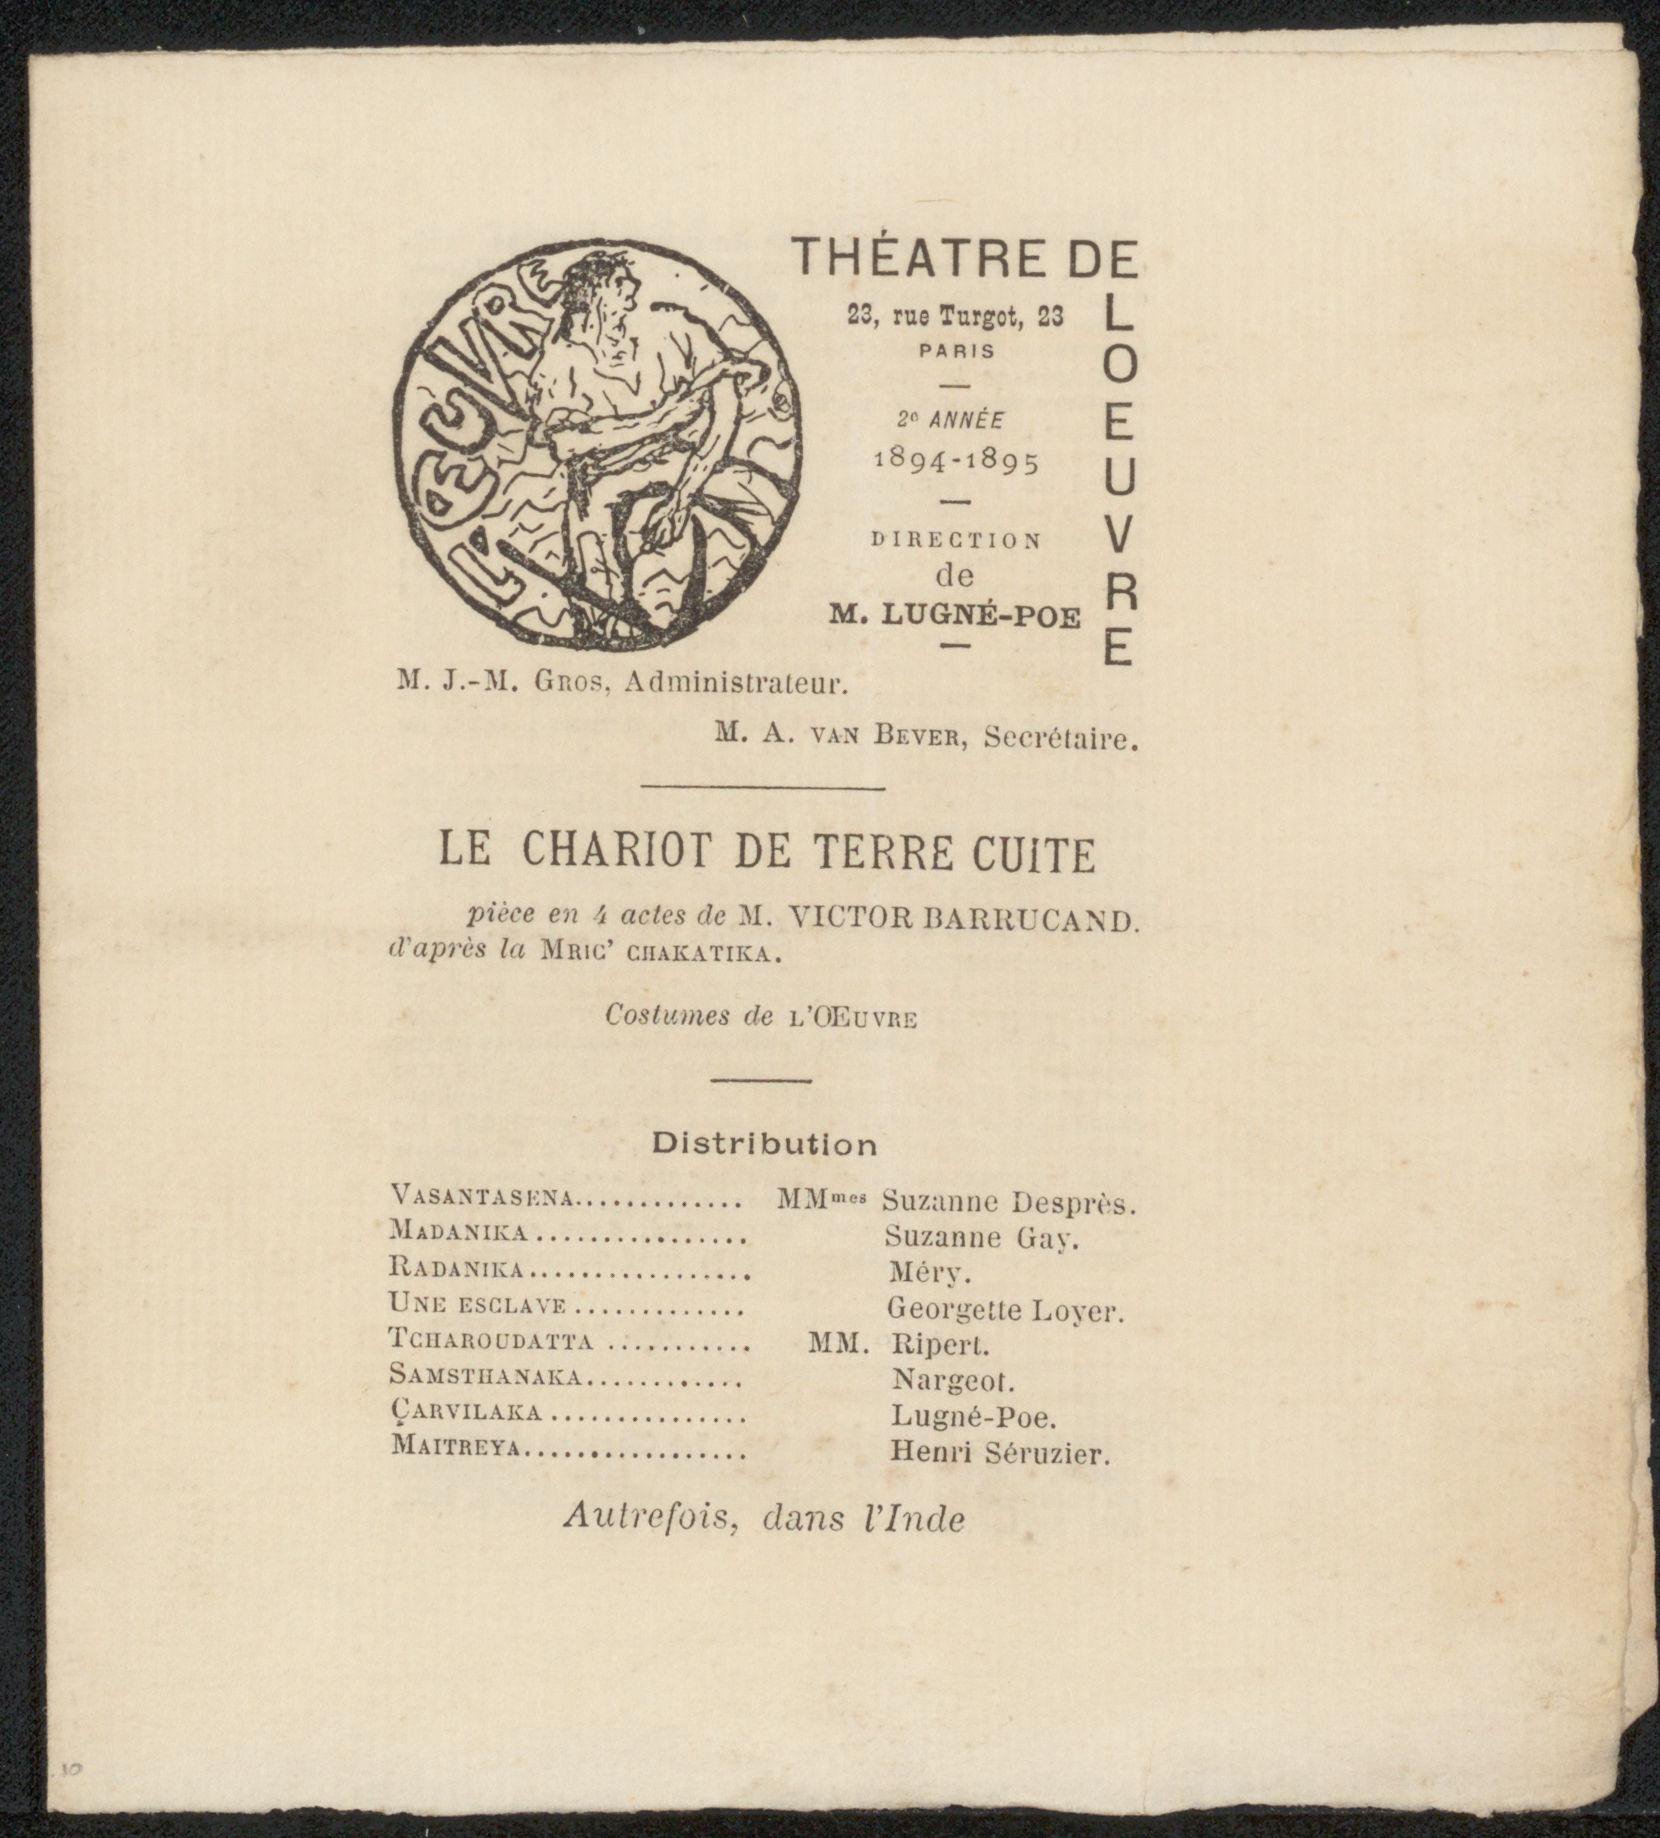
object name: brochure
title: Brochure uit archief Philip Zilcken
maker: adolphe van bever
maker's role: bibliograaf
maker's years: 1871-1925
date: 1894-1895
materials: paper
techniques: printing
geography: paris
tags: lugné-poe, victor barrucand, suzanne desprès, the hague, painter, philip zilcken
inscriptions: collector's mark: ‘RPK’